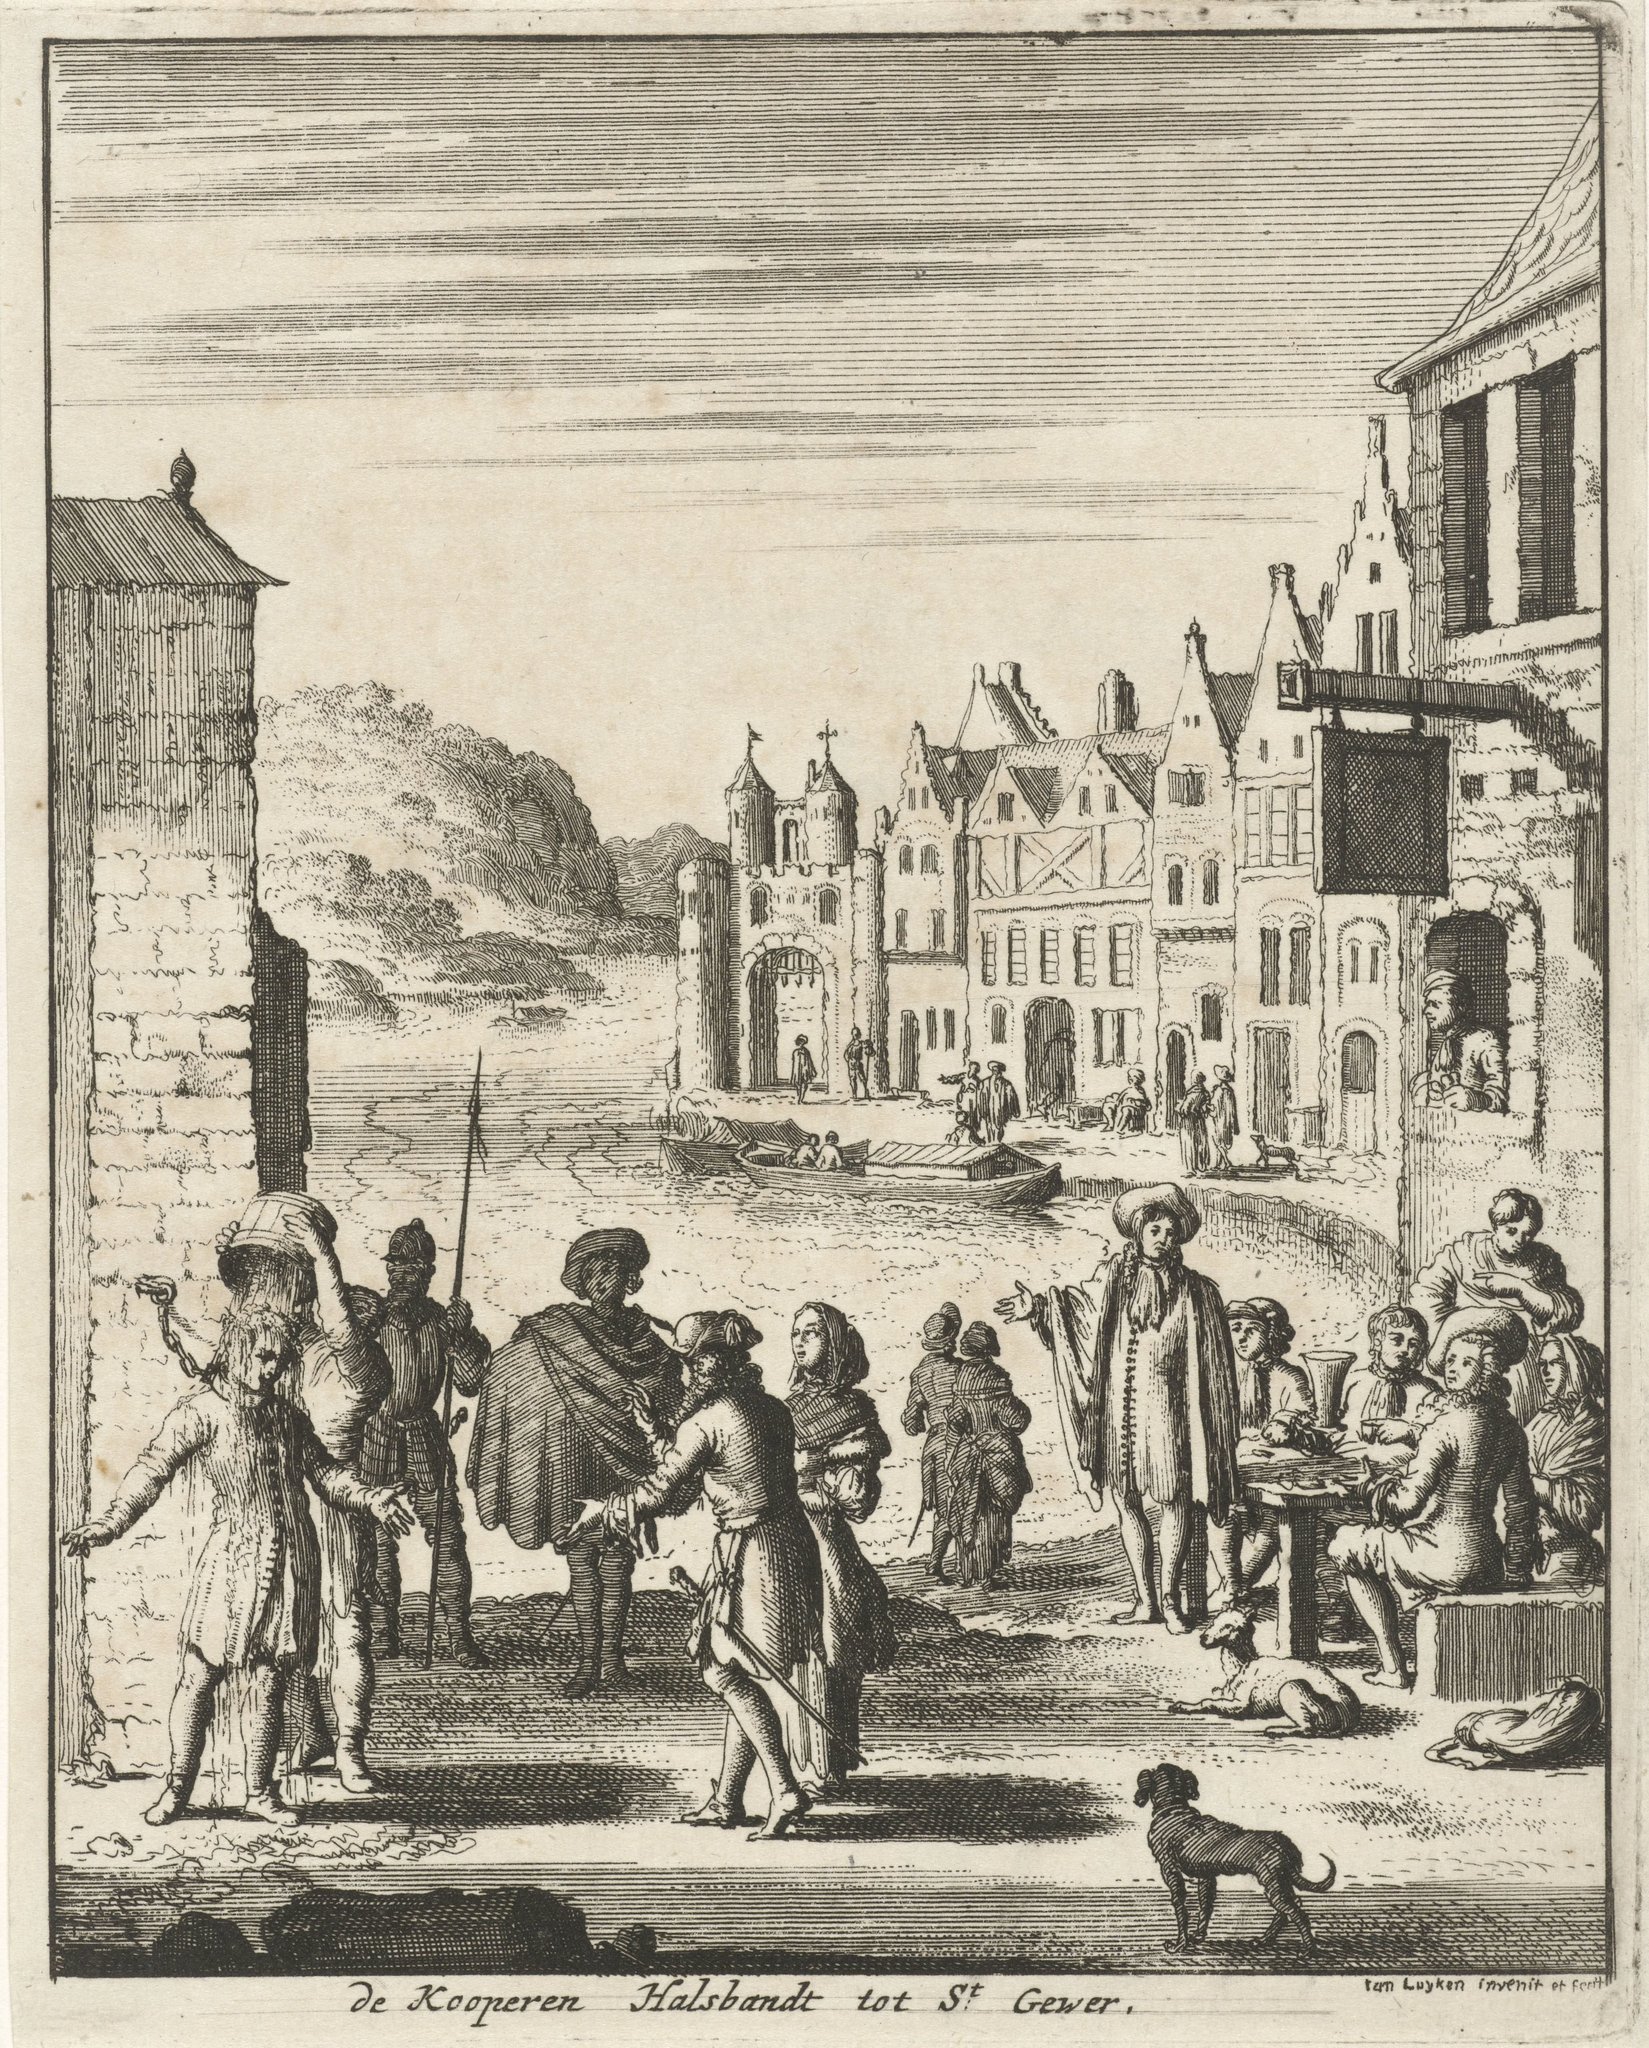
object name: print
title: Doop van vreemdelingen te Sint Goar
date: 1682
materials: paper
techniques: etching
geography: amsterdam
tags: ritual objects and ritual means ~ non-christian religions, hotel, hostelry, inn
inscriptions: collector's mark: Lugt 2228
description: Illustratie opgenomen in: Brown, Edward. Naauwkeurige en gedenkwaardige reysen van Edward Brown (...) door Nederland, Duytsland, Hongaryen, Boek I, p. 59. Amsterdam: Jan Claesz ten Hoorn, 1682.